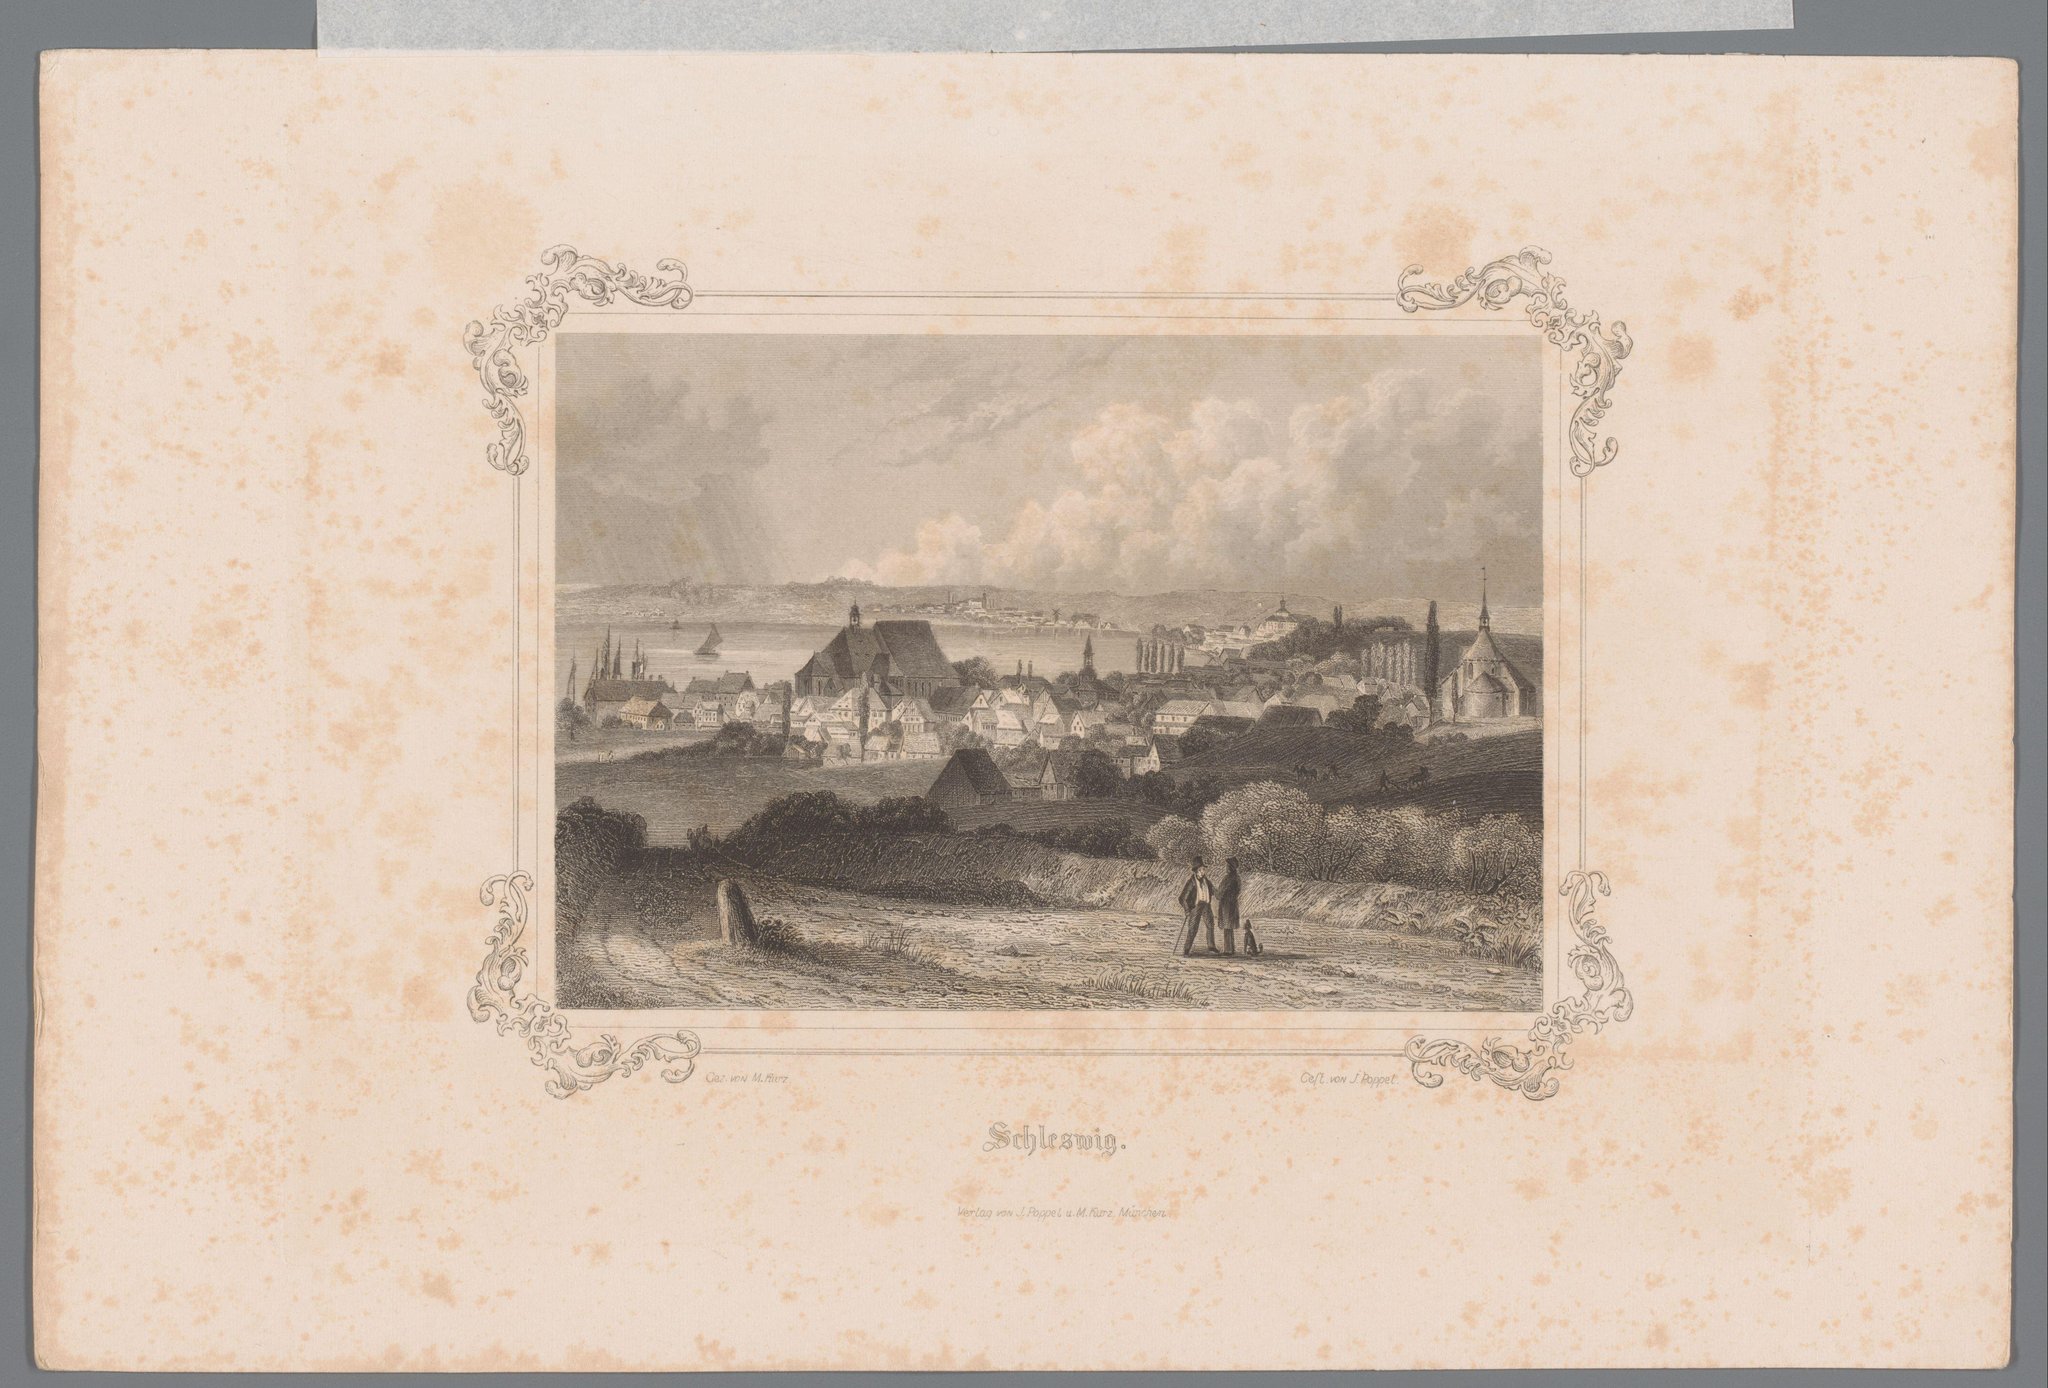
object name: print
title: Gezicht op Sleeswijk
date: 1847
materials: paper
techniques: engraving, etching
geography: munich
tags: city-view in general; 'veduta' (+ city(-scape) with figures, staffage)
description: Deze prent behoort tot deel één of twee van de serie 'Landschappen in Sleeswijk-Holstein'. Het betreft een vierdelige reeks uitgegeven in twee omslagen waarvan deze omslag deel één en twee bevat met daarin zes landschappen en zes tekstbladen.